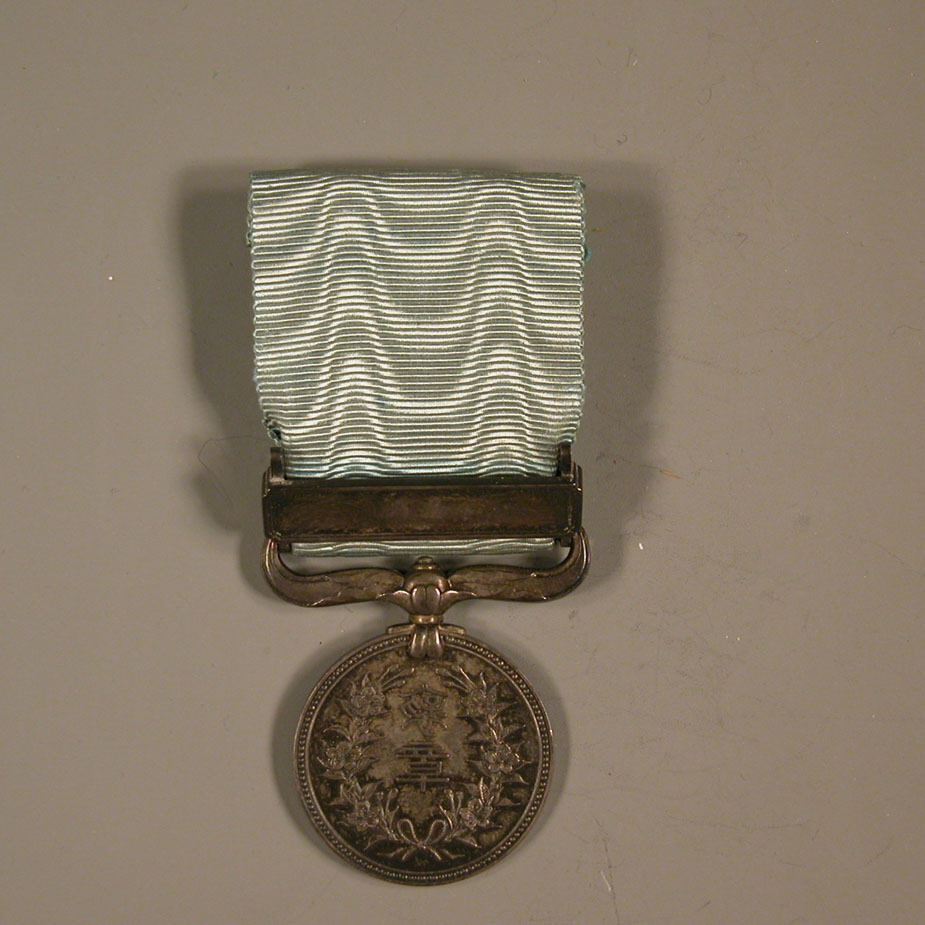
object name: medal of honor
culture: japanese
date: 1867-1900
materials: ribbon